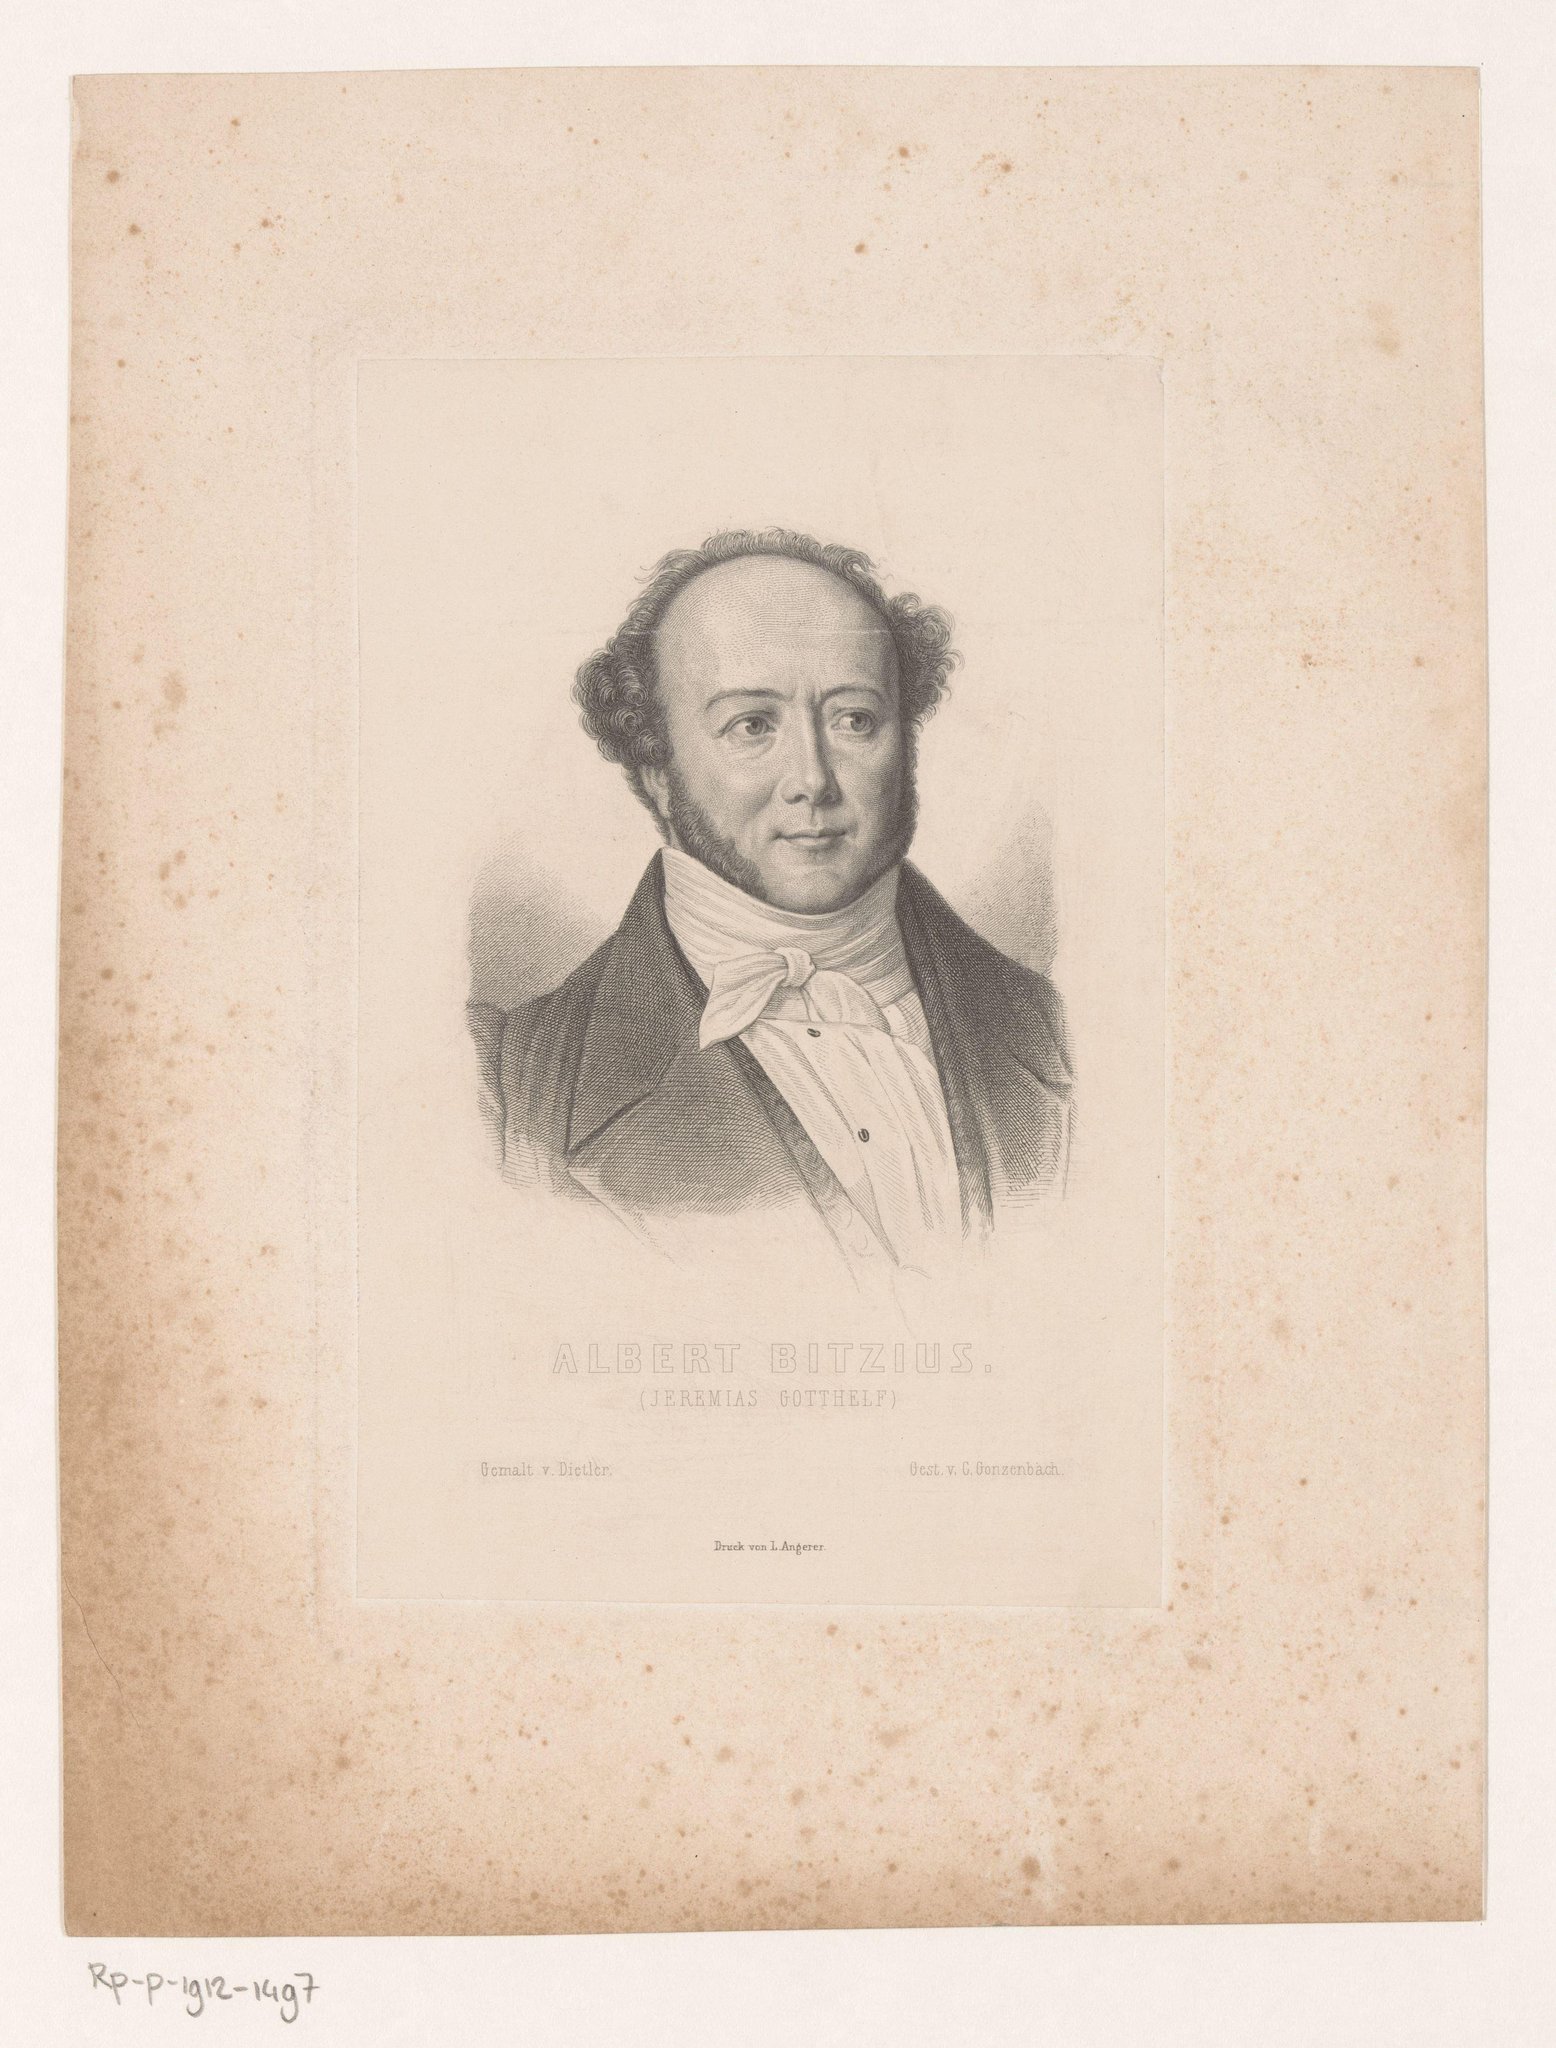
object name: print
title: Portret van Albert Bitzius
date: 1845-1882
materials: paper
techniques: engraving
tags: theologian, historical persons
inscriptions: collector's mark: Lugt 2228